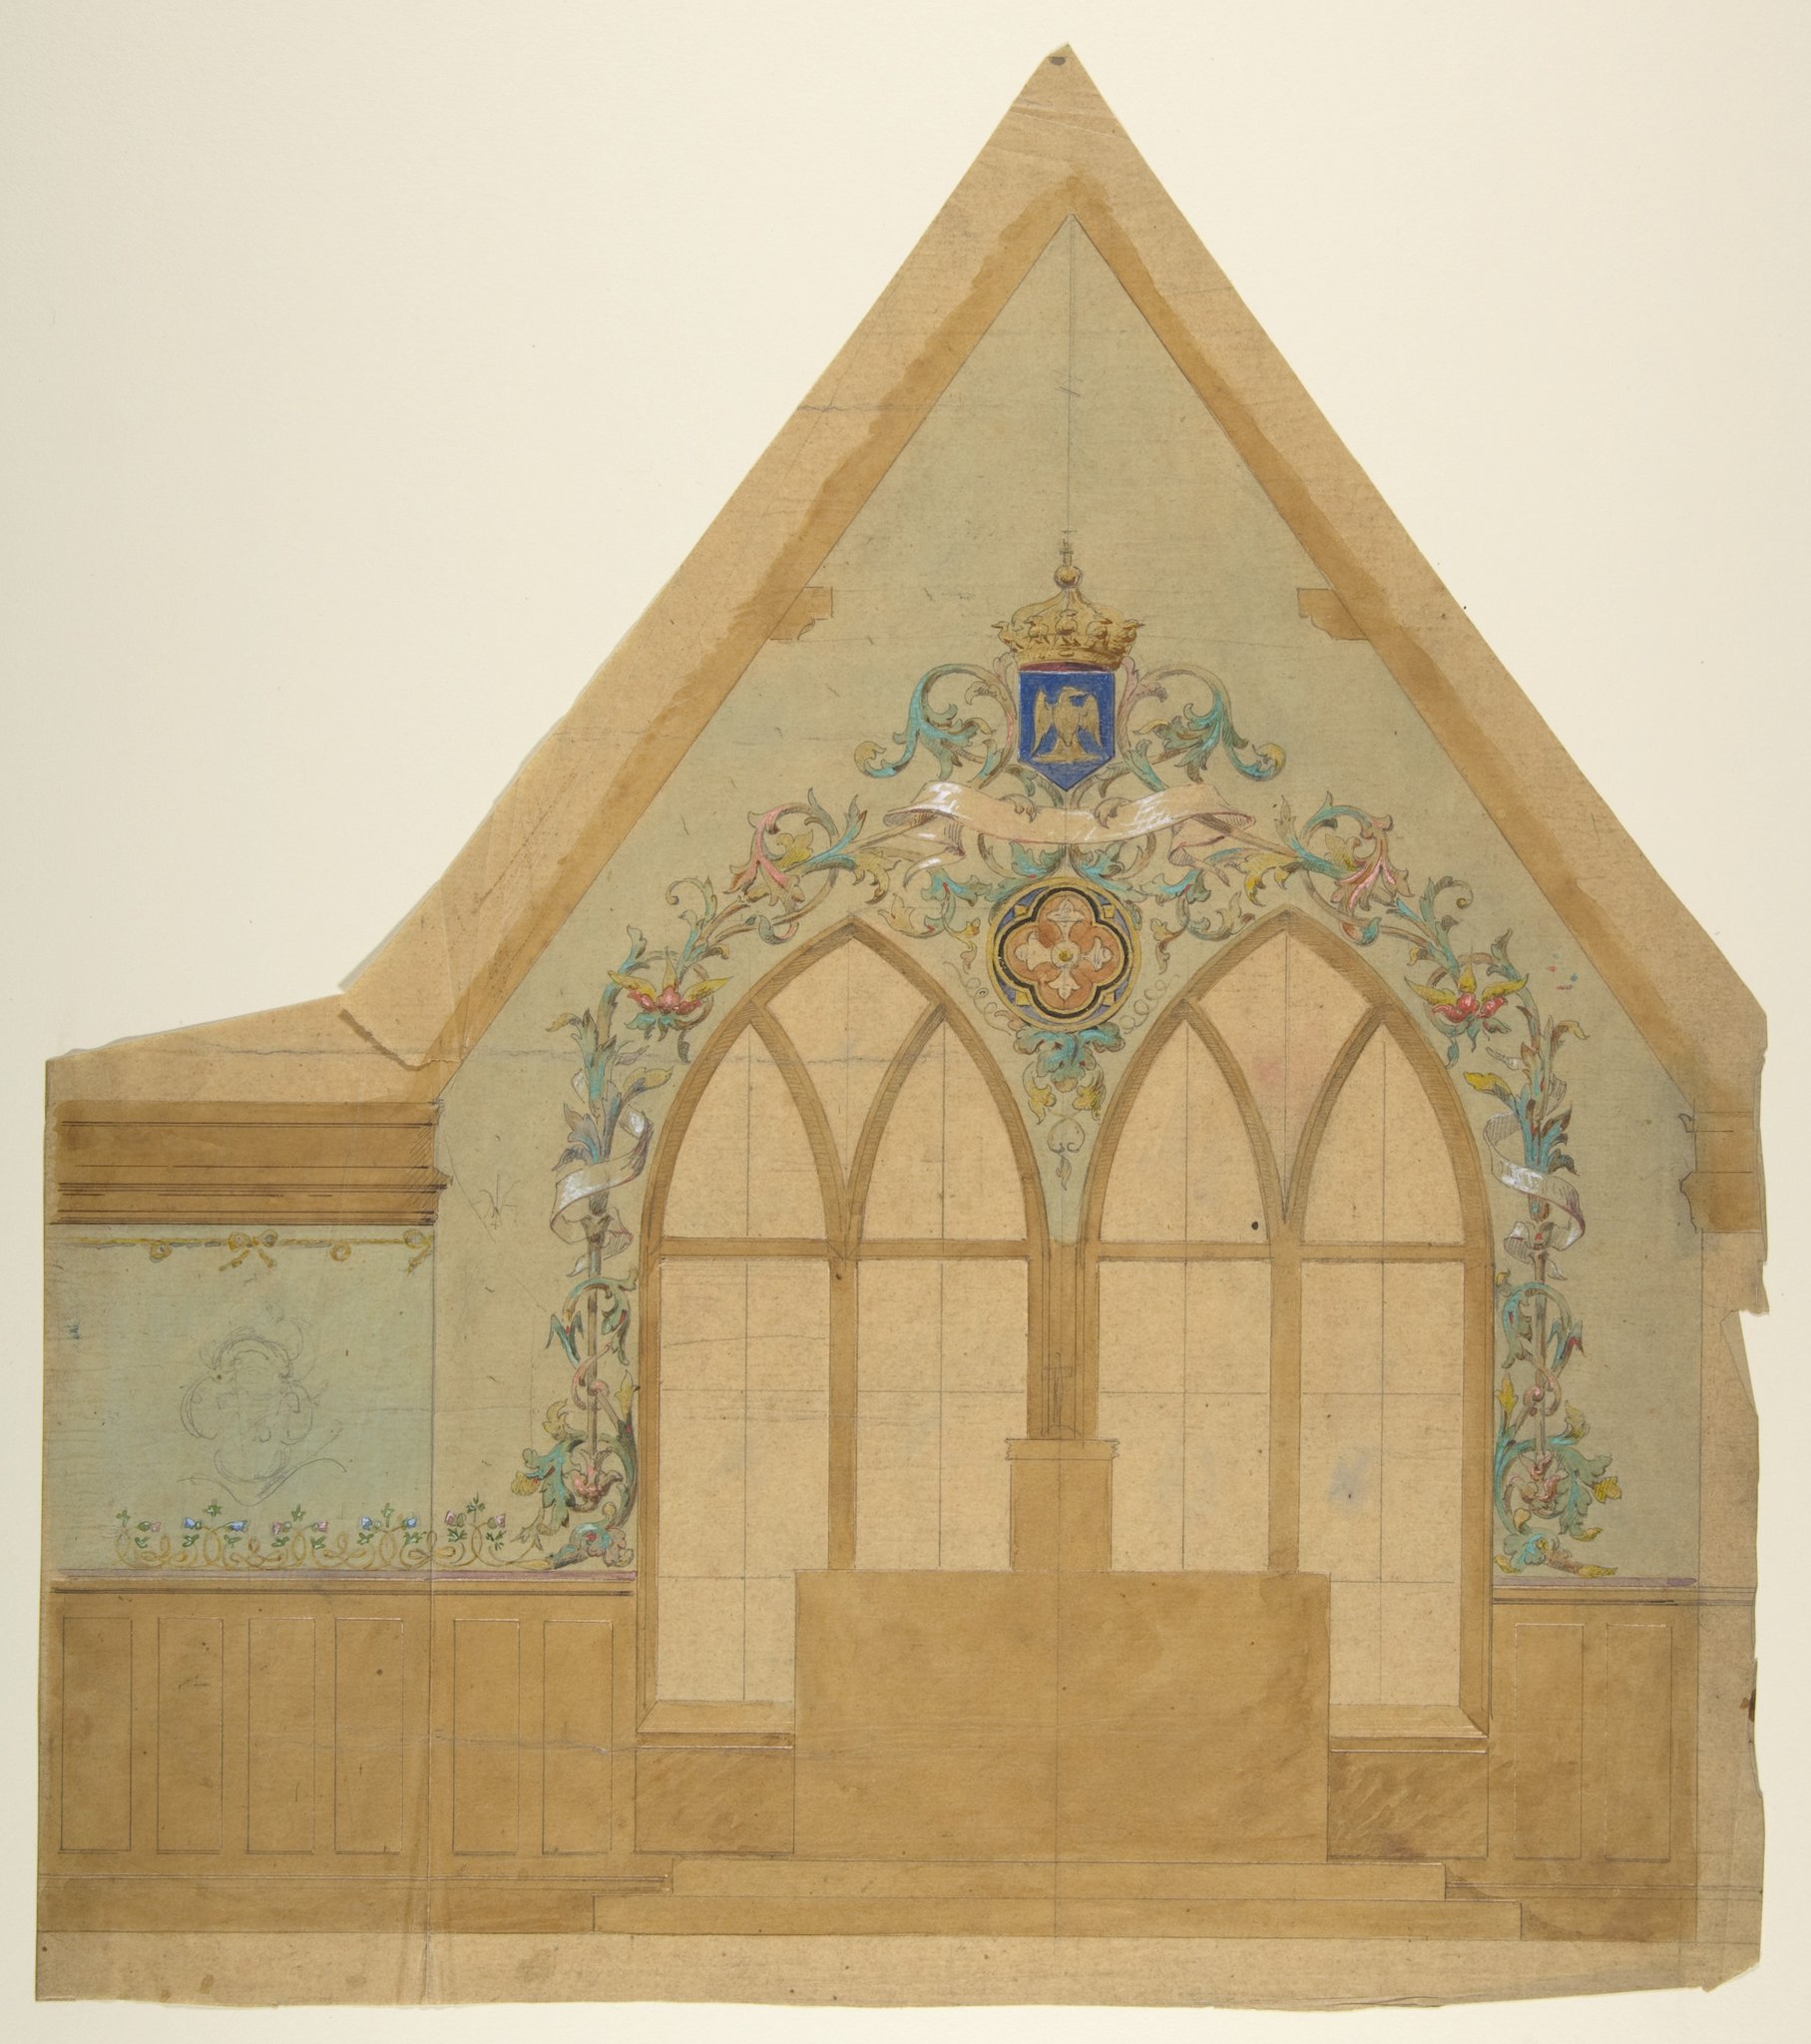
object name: drawing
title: Design for an Altar Chapel, Farnborough, England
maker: jules-edmond-charles lachaise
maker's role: artist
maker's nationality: french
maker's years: 1897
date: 1880-1886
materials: gilt, gouache, graphite, paper, watercolor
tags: birds,altars,ornament,insignia